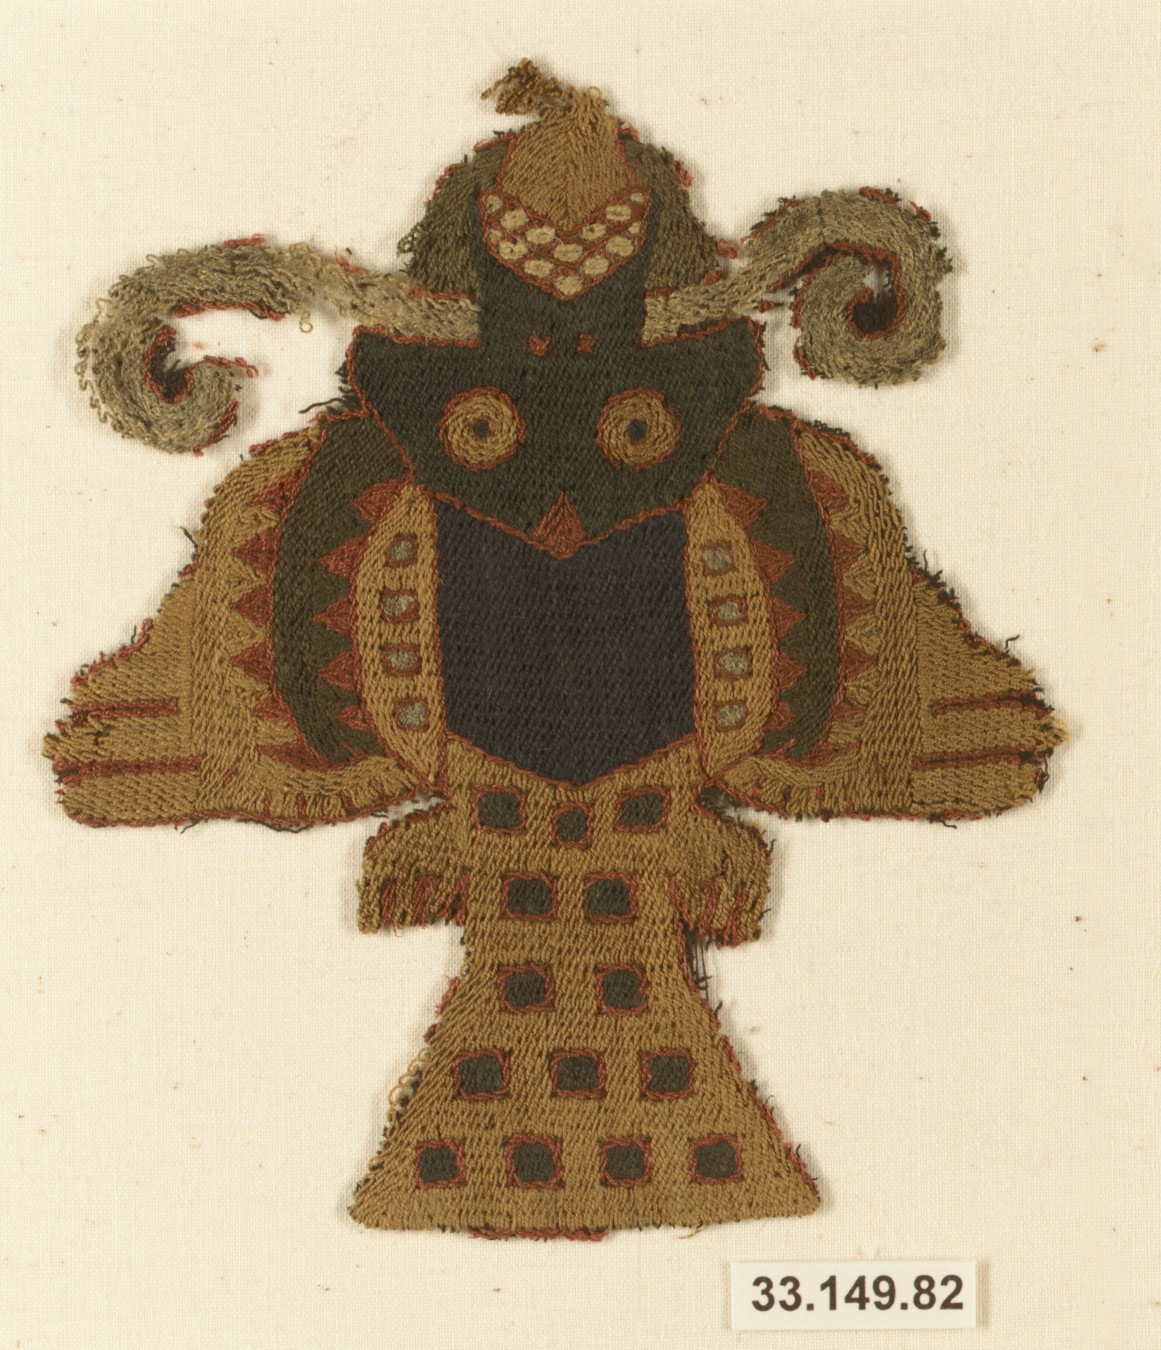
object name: textile fragment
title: Embroidered Fragment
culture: paracas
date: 400-201 BCE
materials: animal fiber, cotton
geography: peru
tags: birds